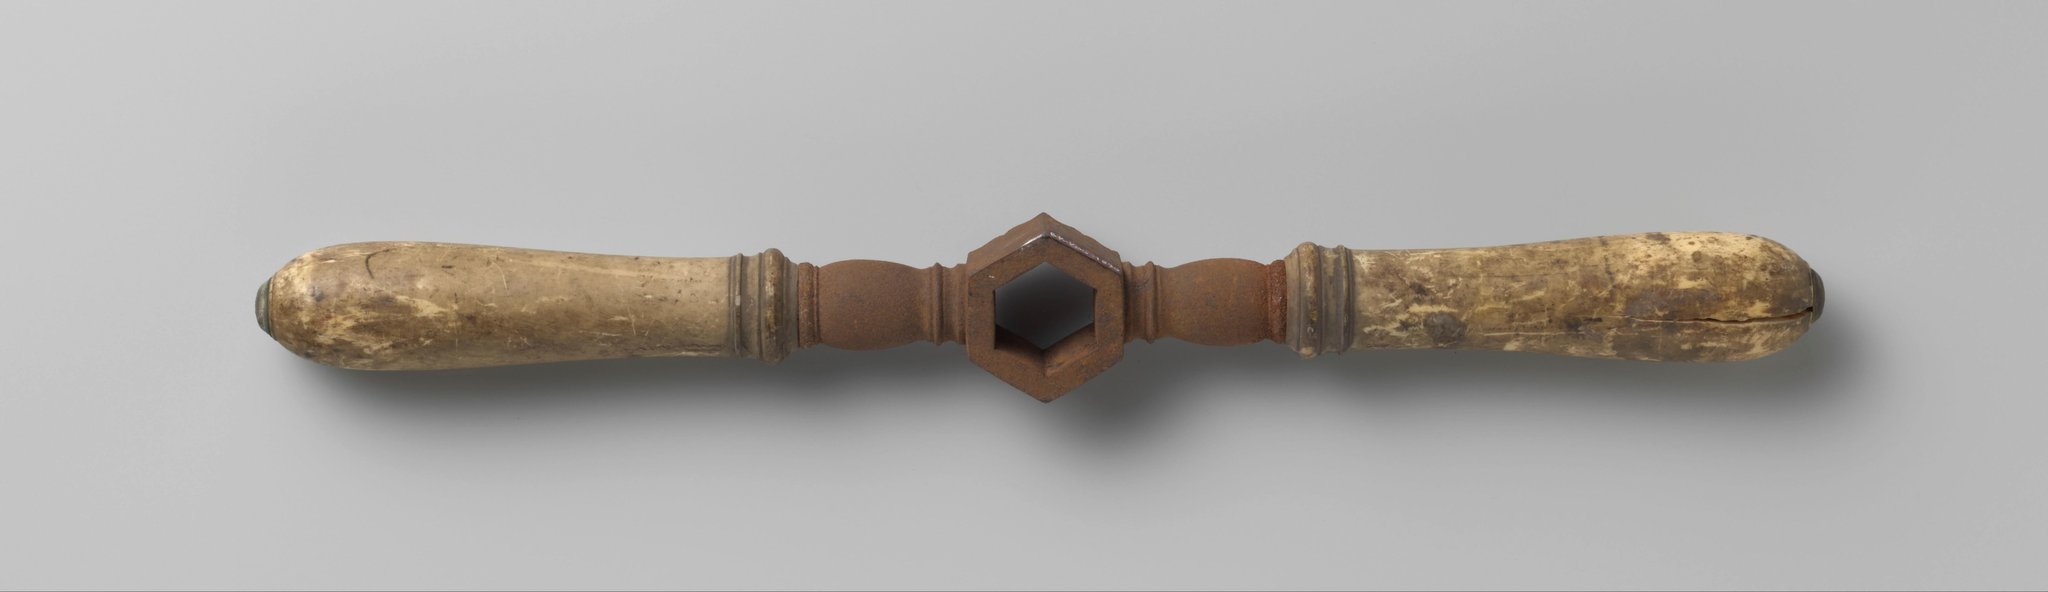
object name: socket wrench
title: Dopsleutel, zestkantig, met twee handvatten van been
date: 1400-1950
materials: bone, iron